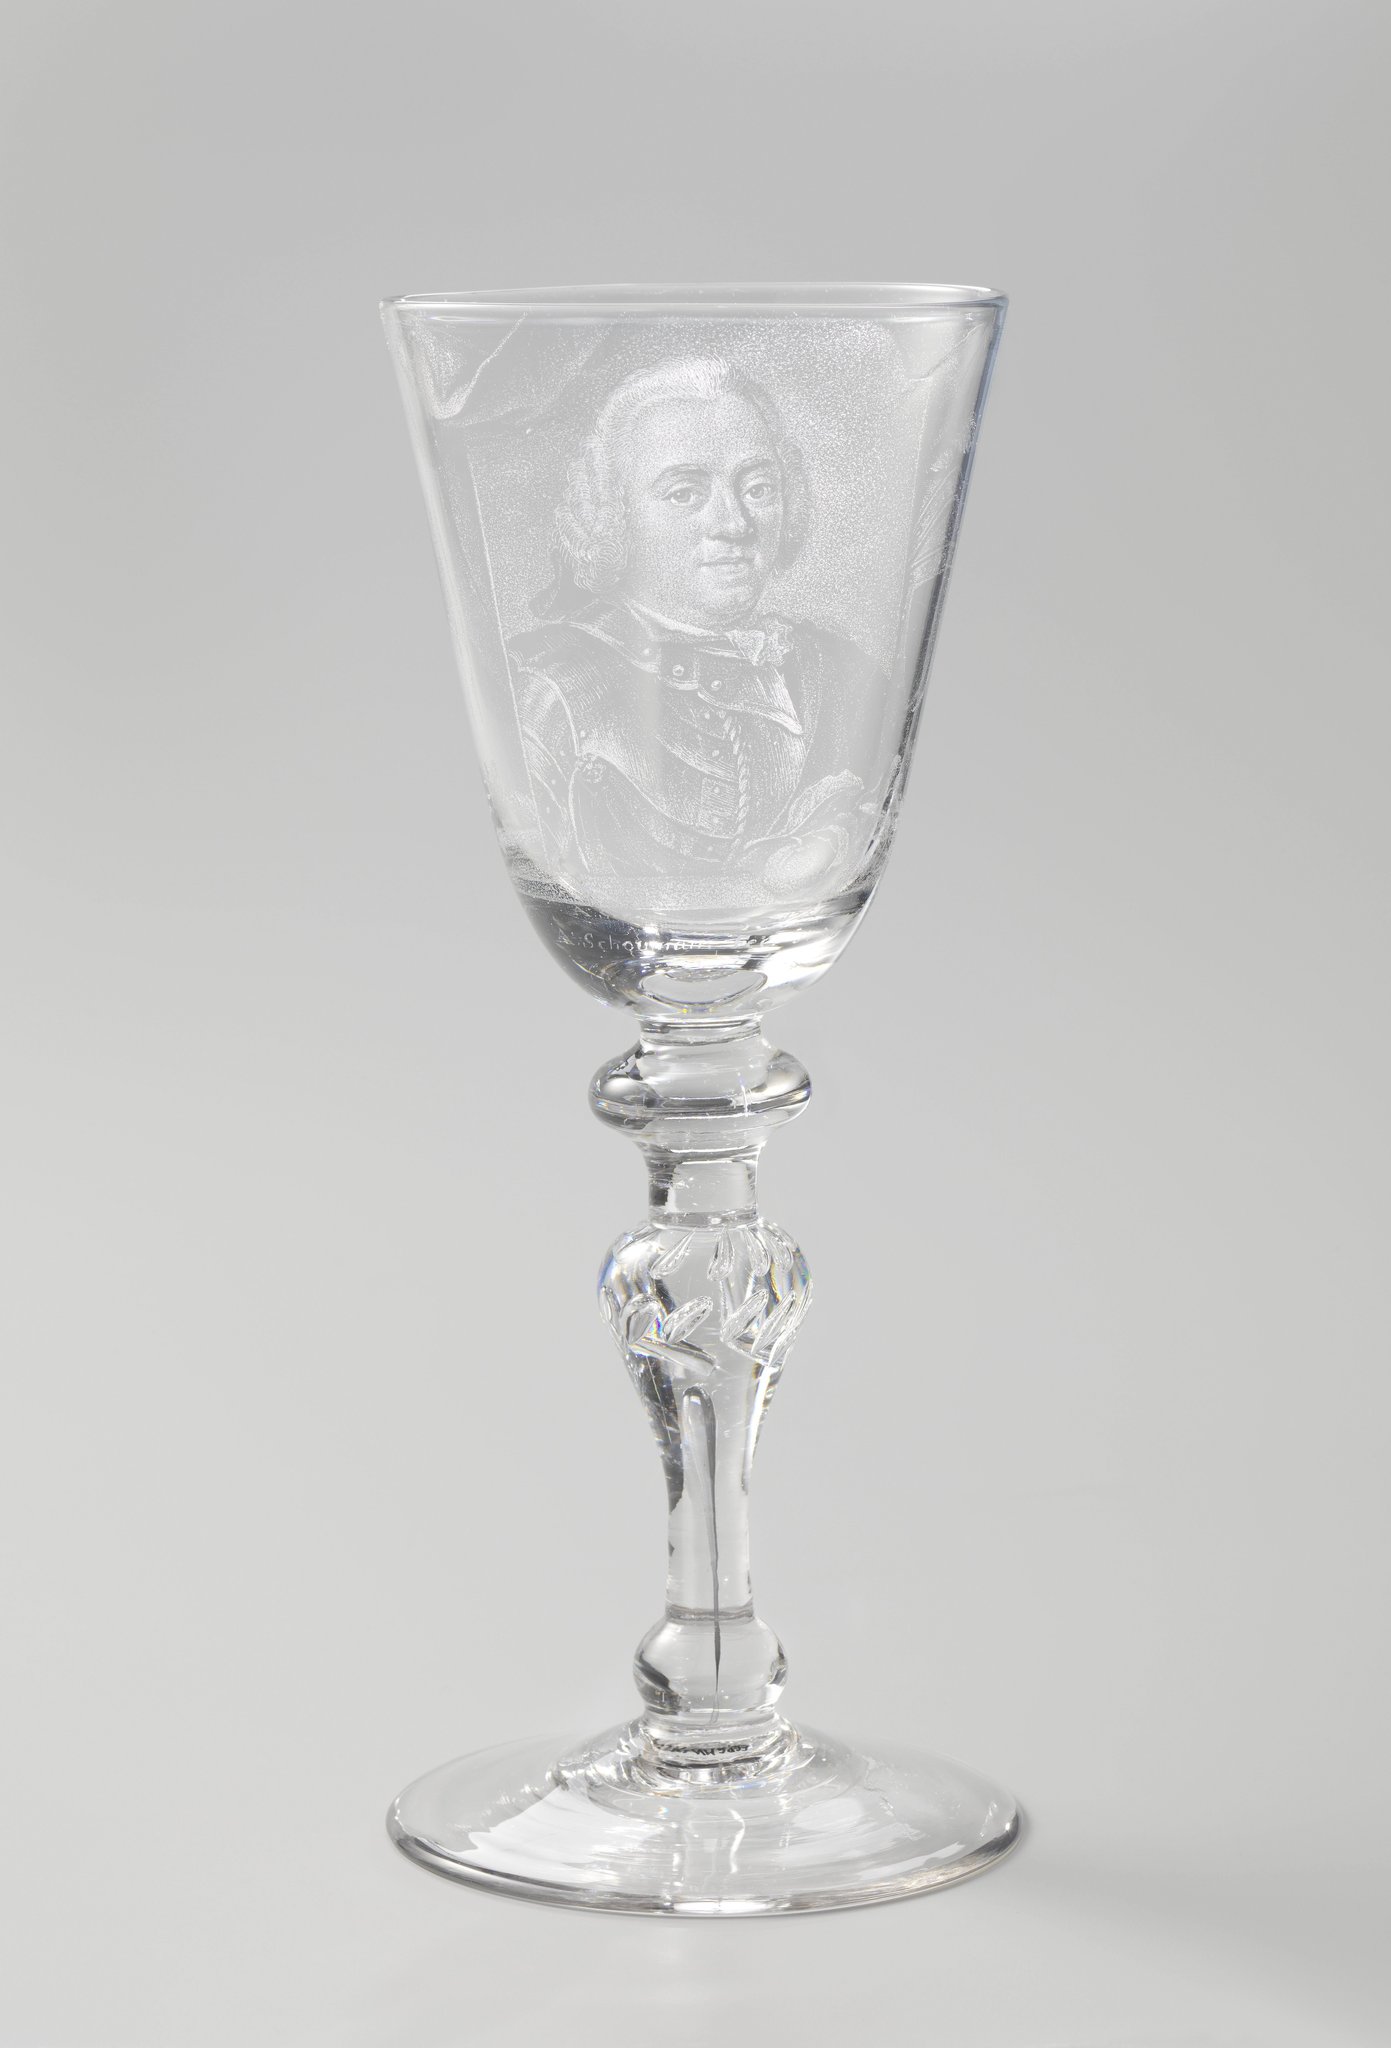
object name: goblet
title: Goblet with a portrait of William IV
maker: aert schouman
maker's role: draughtsman, painter, print maker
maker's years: 1710-1792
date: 1750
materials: glass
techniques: glassblowing, engraving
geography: rotterdam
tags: the hague, willem iv (prins van oranje-nassau), historical persons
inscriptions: signature: ‘A:Schouman. Fec=1750’, inscription: ‘HONI SOIT QUI MAL [Y] PE[NSE]’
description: translation of inscription: Shame on him who thinks evil of it